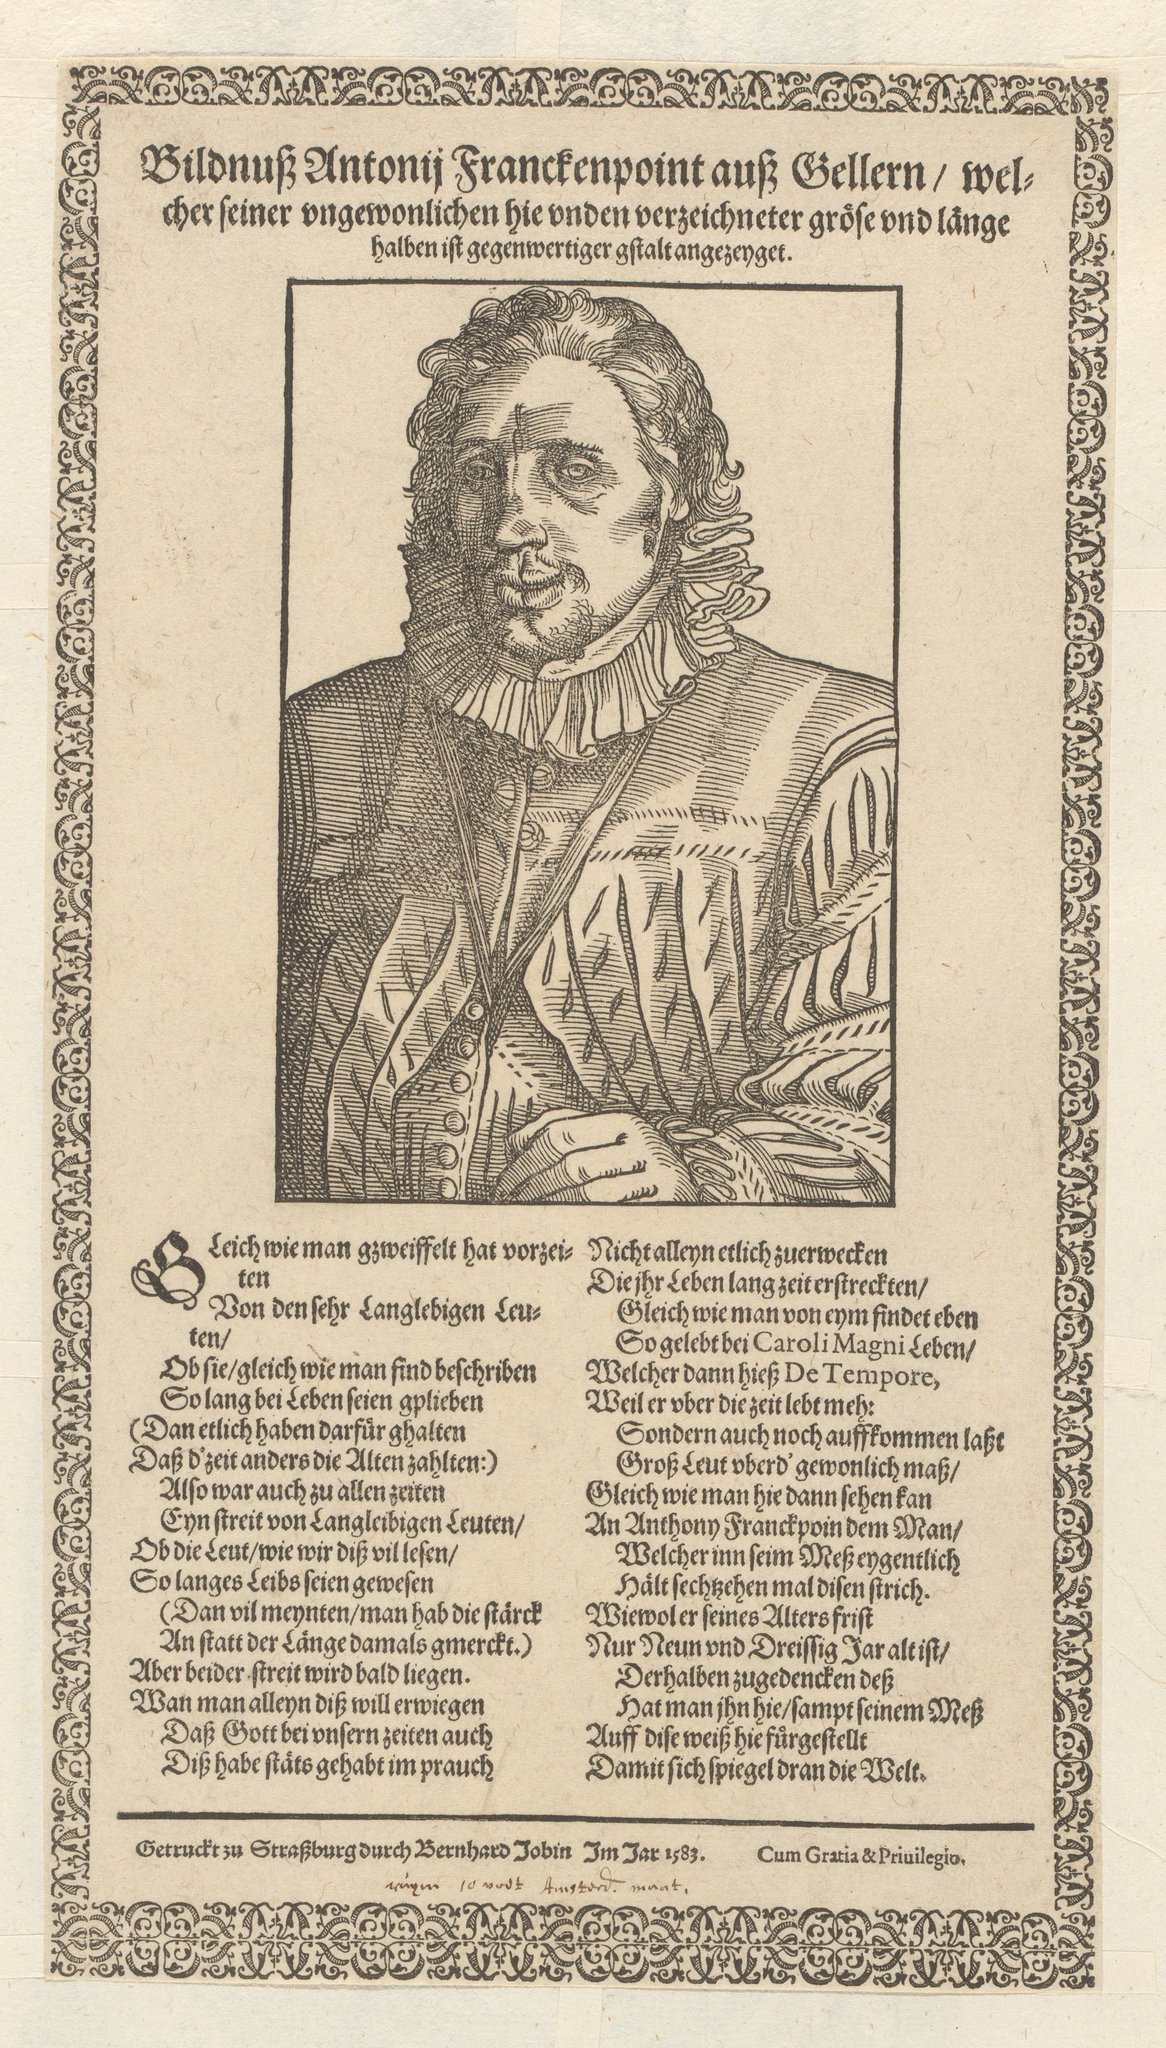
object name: album leaf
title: Portret van Anton de Franckenpoint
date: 1583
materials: paper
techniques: letterpress printing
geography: straatsburg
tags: historical persons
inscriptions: annotation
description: De tekst beschrijft dat de lengte van 'lange Anton' zestien keer de lijn onder de tekst (142 mm) was.